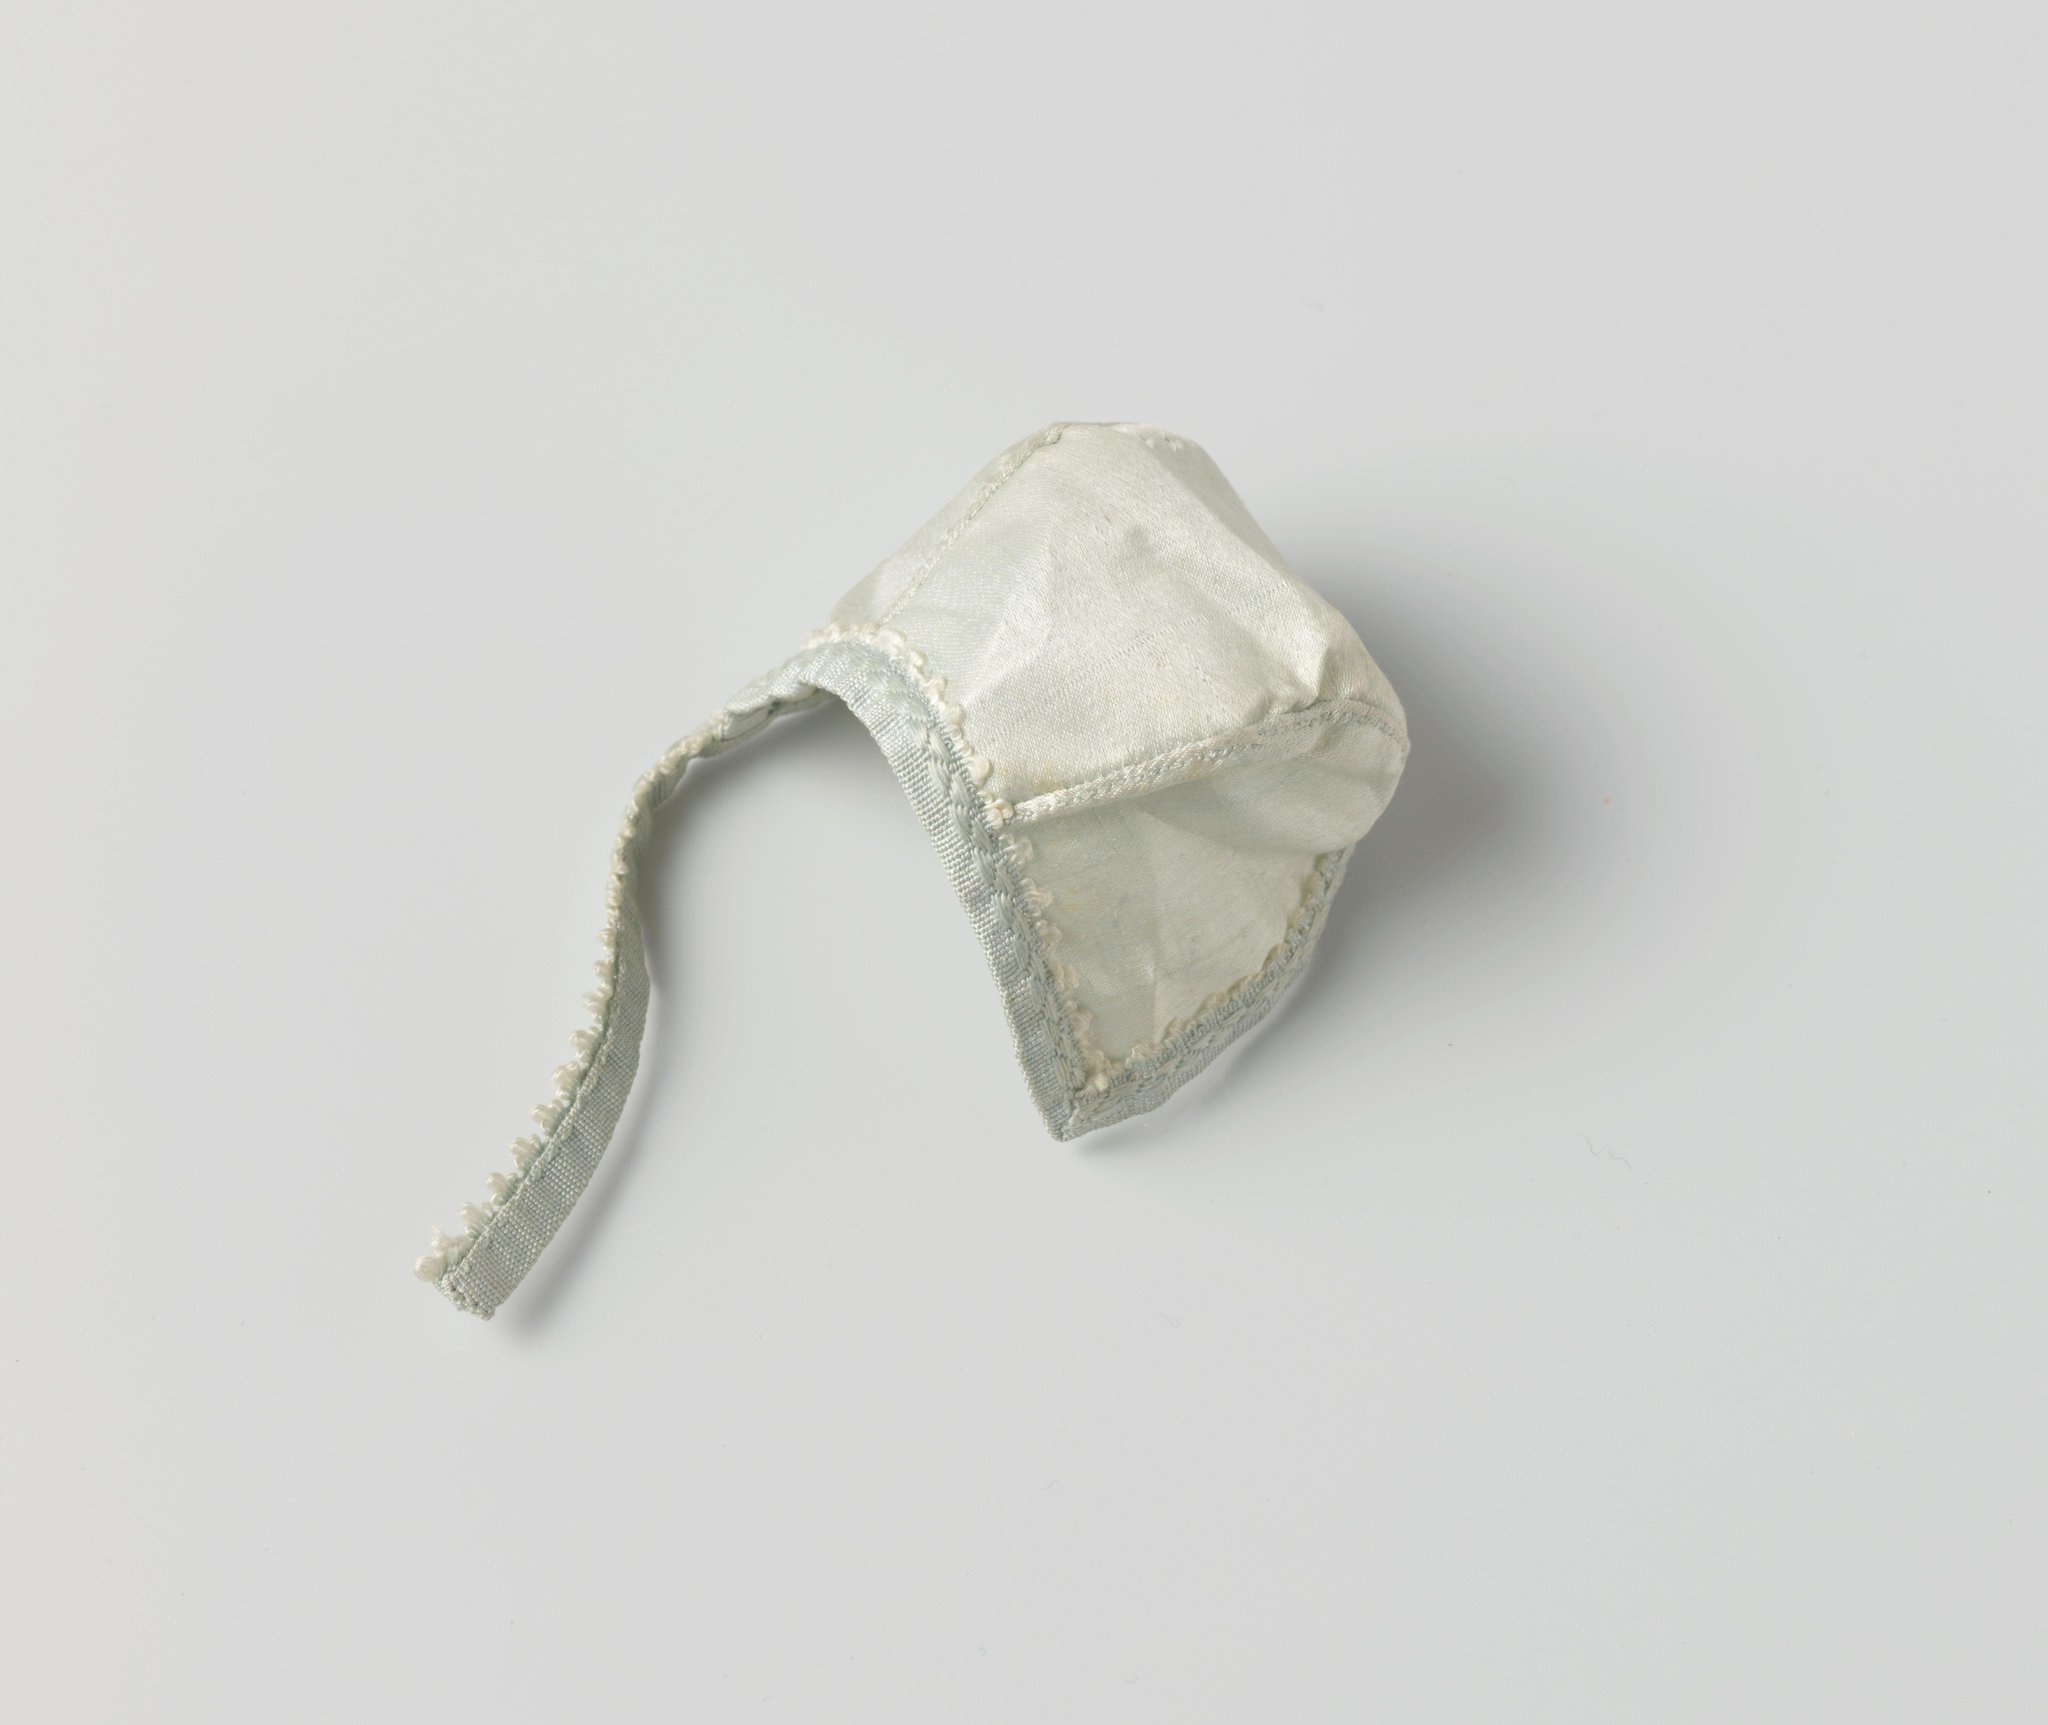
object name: doll's clothing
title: Muts van lichtblauwe zijde in satijnbinding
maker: Anonymous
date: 1650-1700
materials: silk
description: Muts vervaardigd van lichtblauwe zijde in satijnbinding. Deze meisjesmuts heeft twee zijstukken en een van de nek naar het voorhoofd doorlopende middenbaan. De randen zijn afgezet met lichtblauw zijden band met ingeweven zigzagmotief en lusjes; aan de linkerzijde loopt dit bandje door in een sluitband. Zie tevens: BK-NM-5448-7-b. Met betrekking tot de bandjes vergelijk met de dekens van het poppenhuis van P. Dunois en BK-NM-5448, BK-14656-246 en BK-14656-242-a/b.